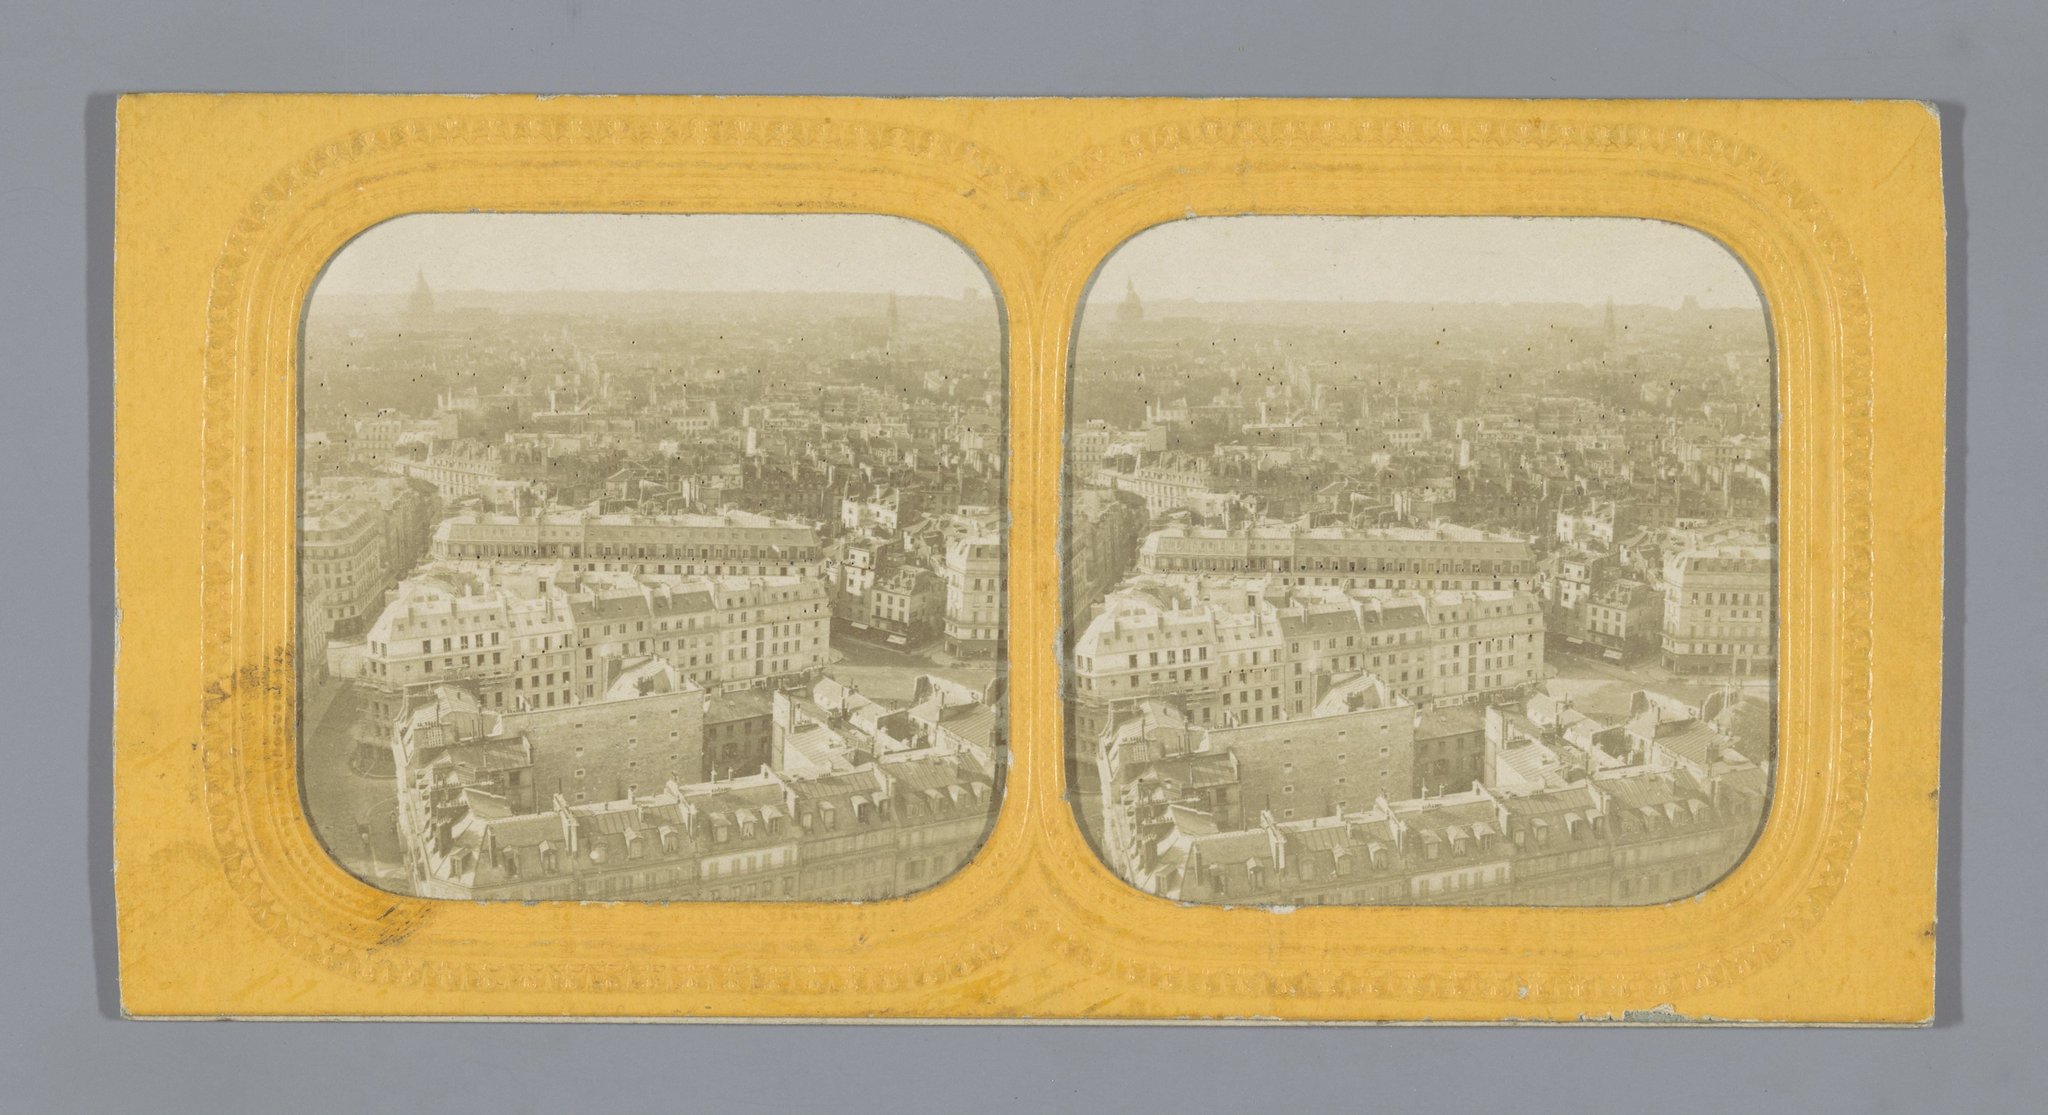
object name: tissue stereograph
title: Gezicht op Parijs, gezien vanaf het Louvre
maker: Anonymous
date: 1855-1875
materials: cardboard, paper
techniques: albumen print, hand coloring, perforating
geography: paris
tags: city-view in general; 'veduta', paris